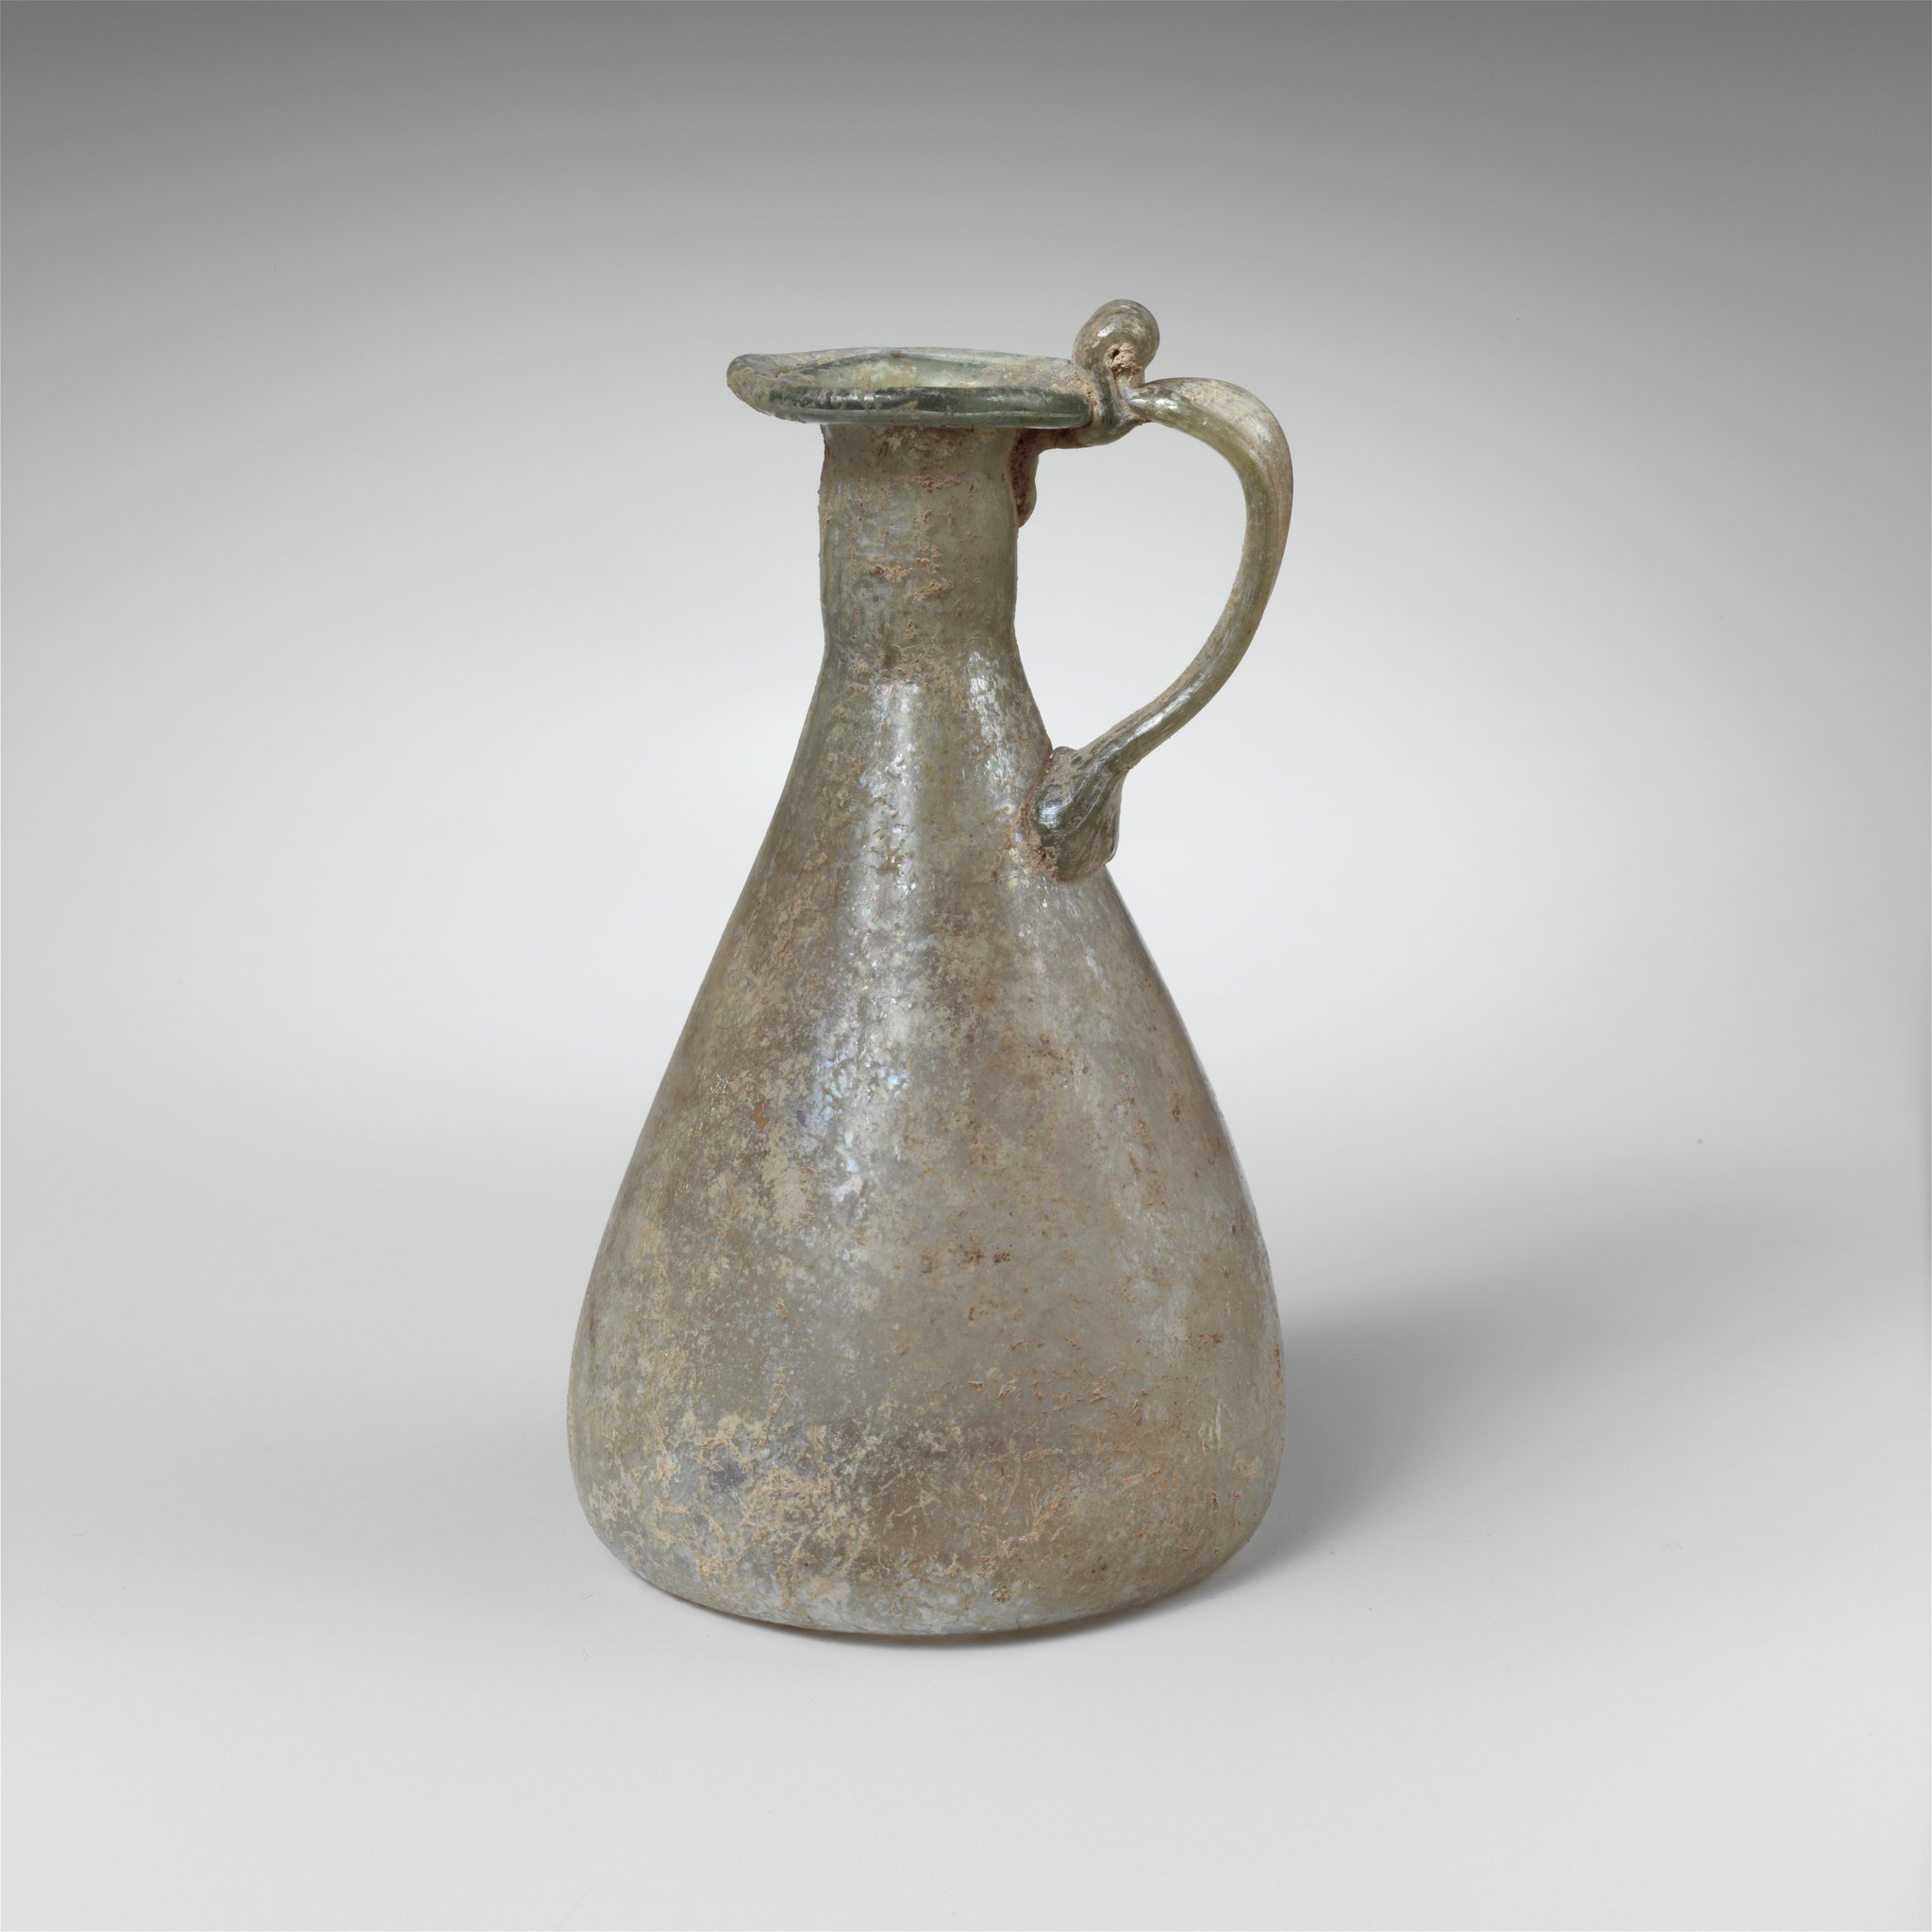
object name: jug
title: Glass jug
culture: roman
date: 1-200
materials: glass